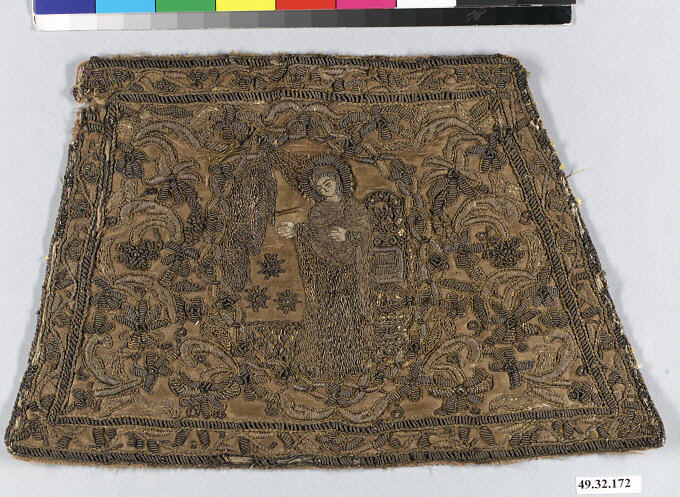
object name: cuff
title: Liturgical cuff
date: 1601-1700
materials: silk, silver, silver gilt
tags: virgin mary